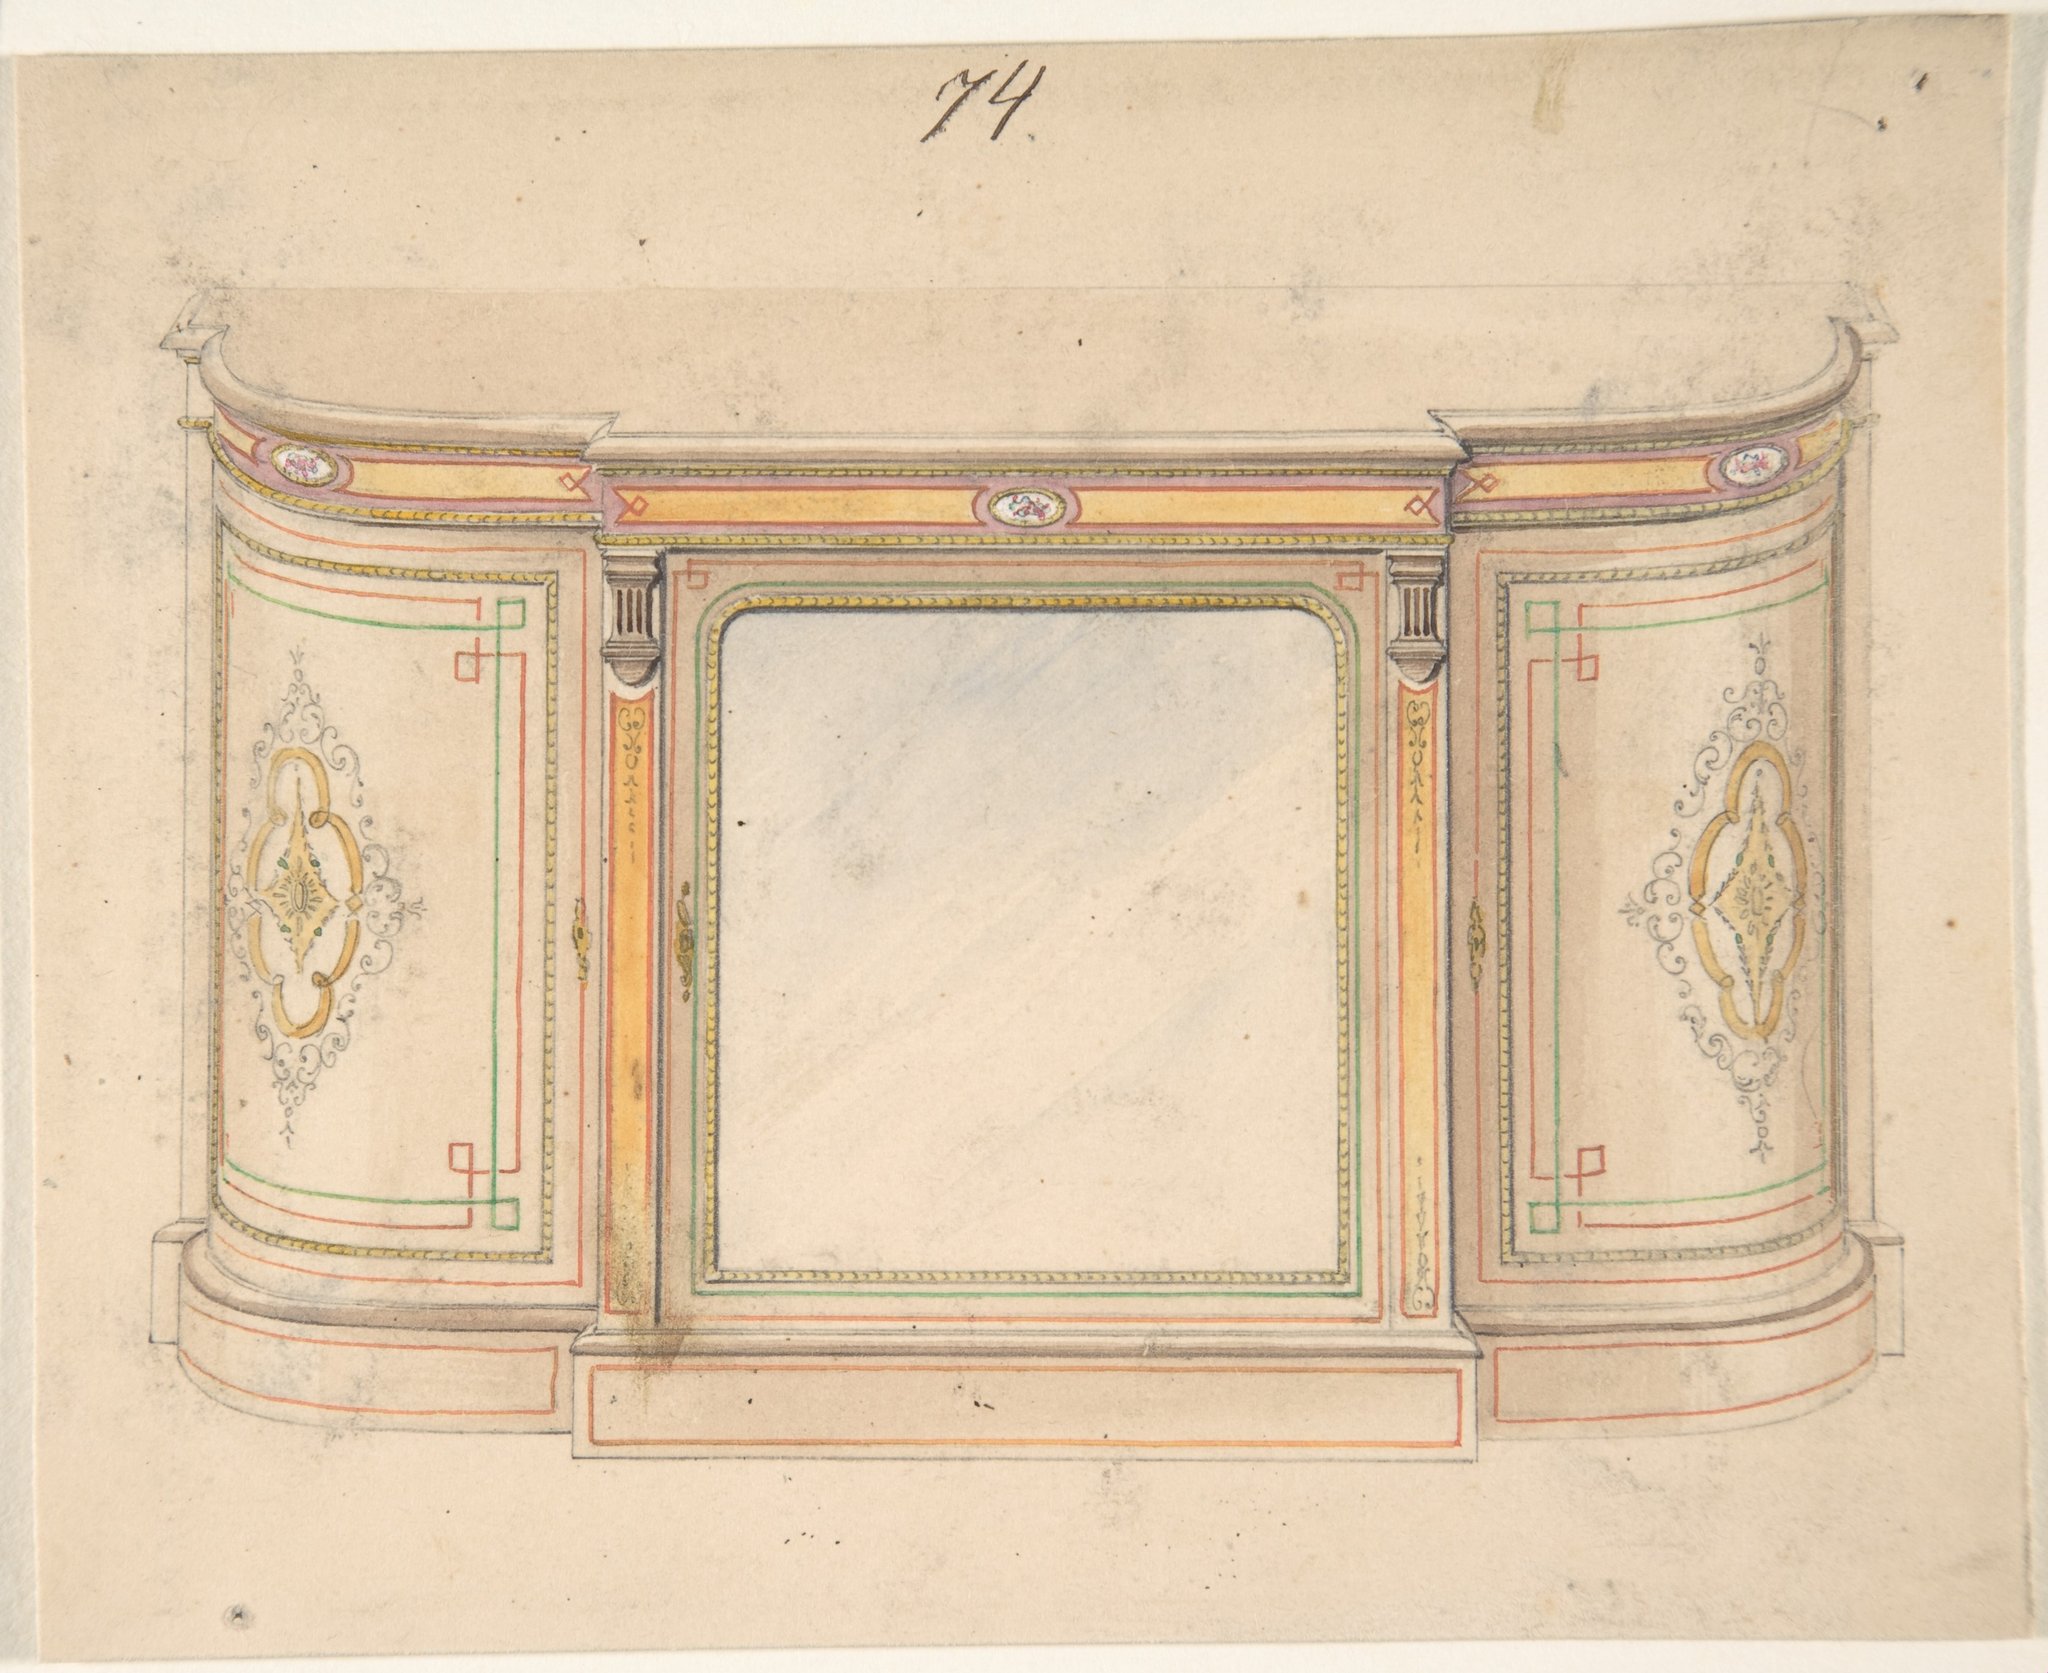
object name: drawing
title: Cabinet Design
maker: anonymous, british, 19th century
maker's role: artist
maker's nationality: british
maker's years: 1800-1900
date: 1801-1900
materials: graphite, ink, watercolor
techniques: pen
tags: cabinets